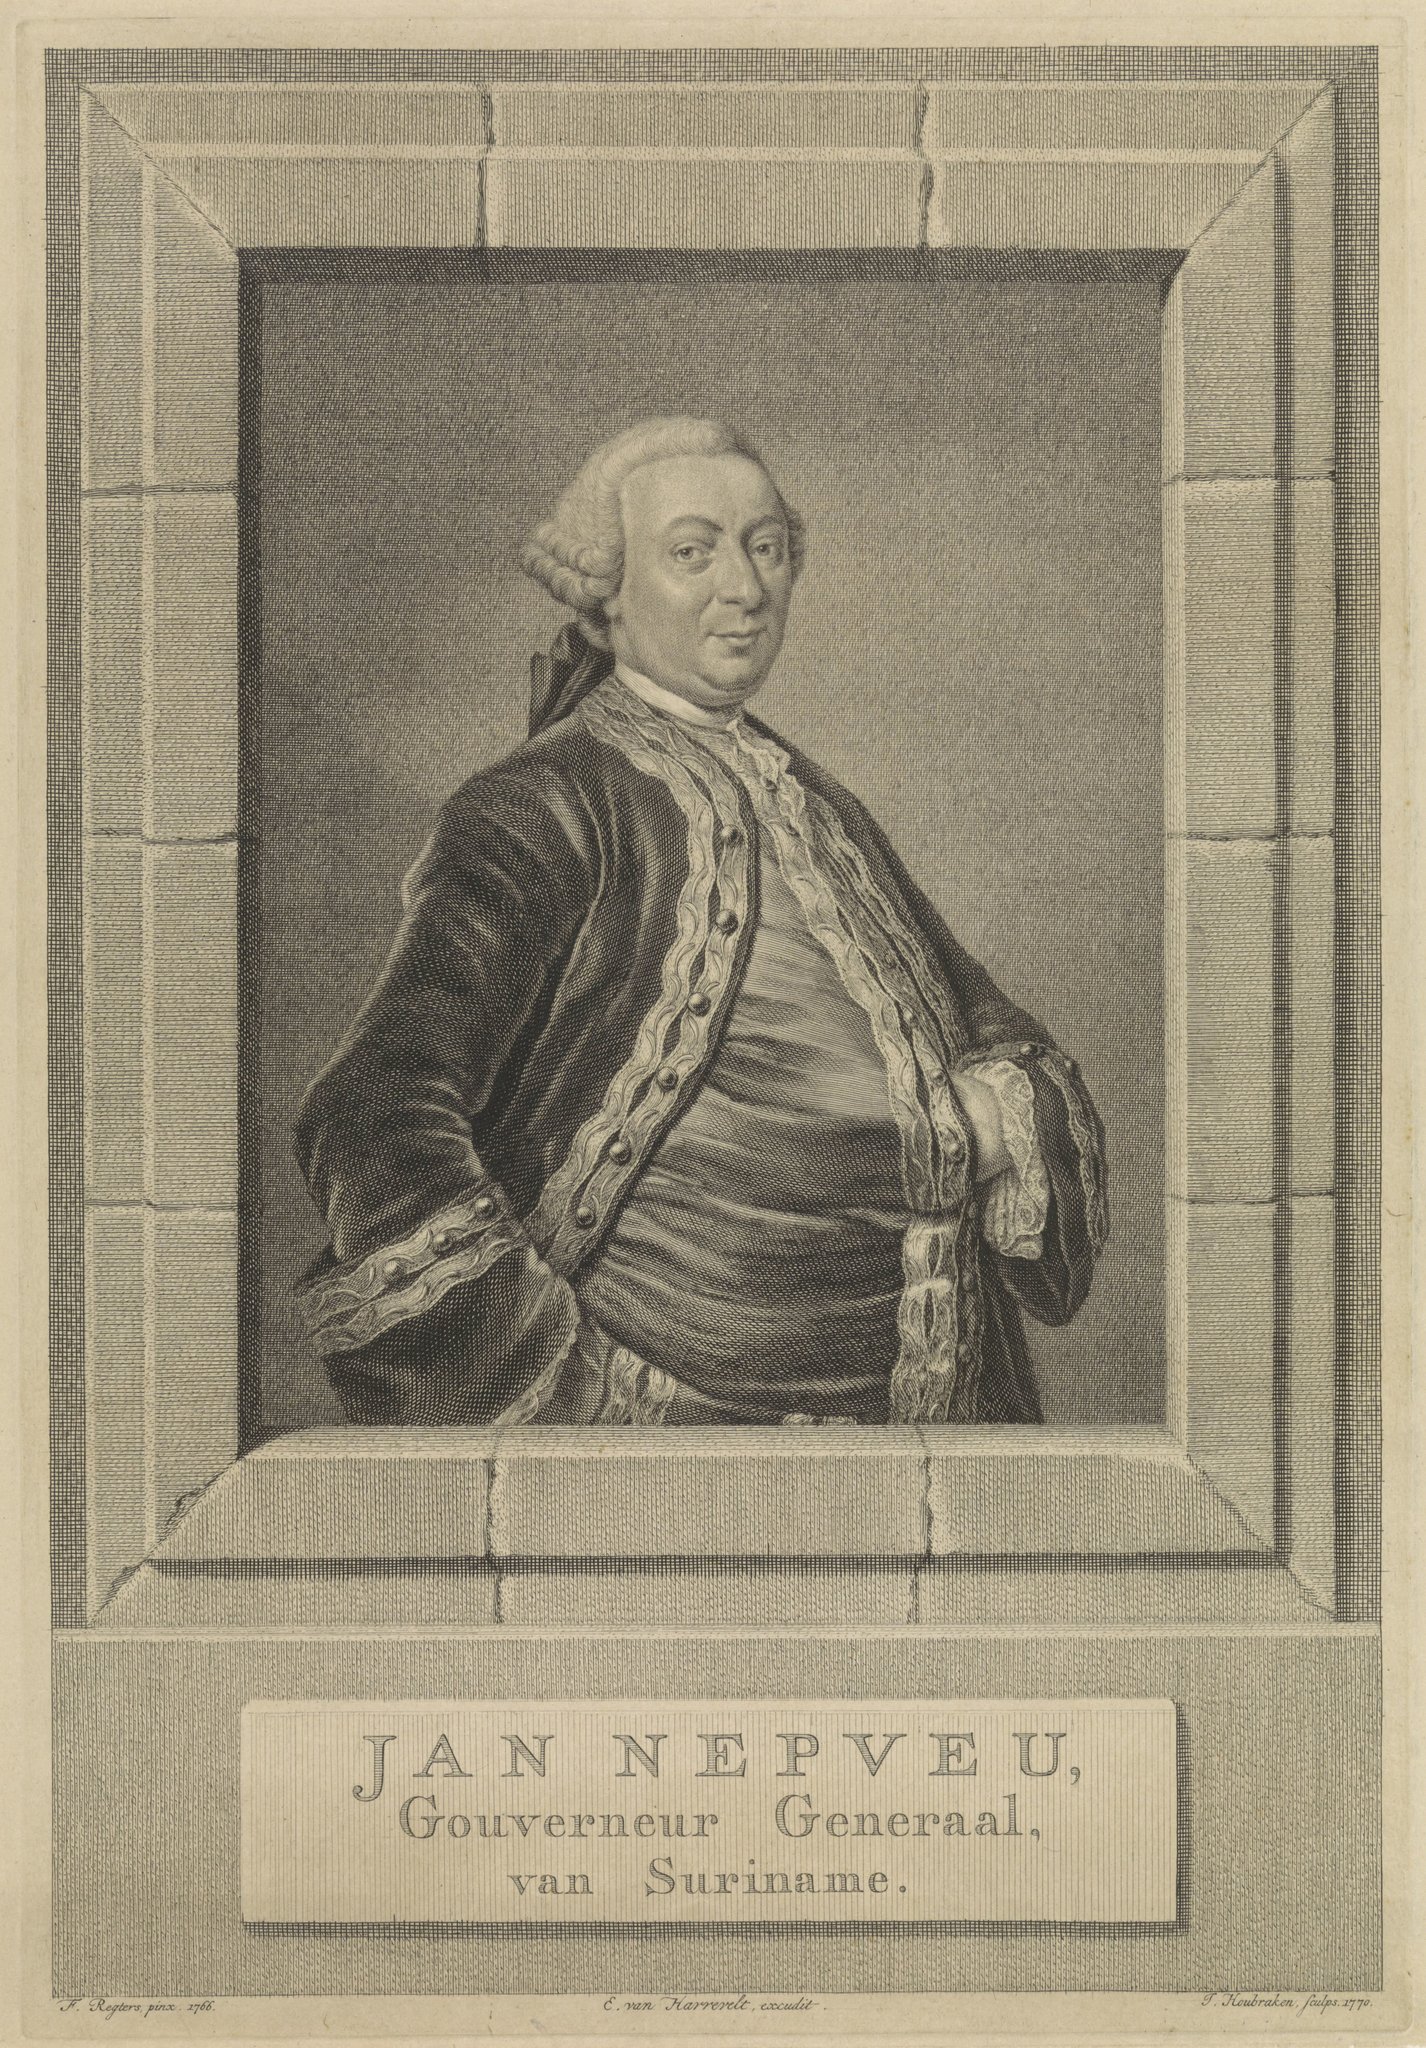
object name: print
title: Jan Nepveu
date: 1770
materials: paper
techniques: engraving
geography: amsterdam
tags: amsterdam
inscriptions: collector's mark: Lugt 240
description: Portret ten halven lijve naar rechts van Jan Nepveu in een architectonisch venster. Onder het portret zijn naam en titel in drie regels in het Nederlands.